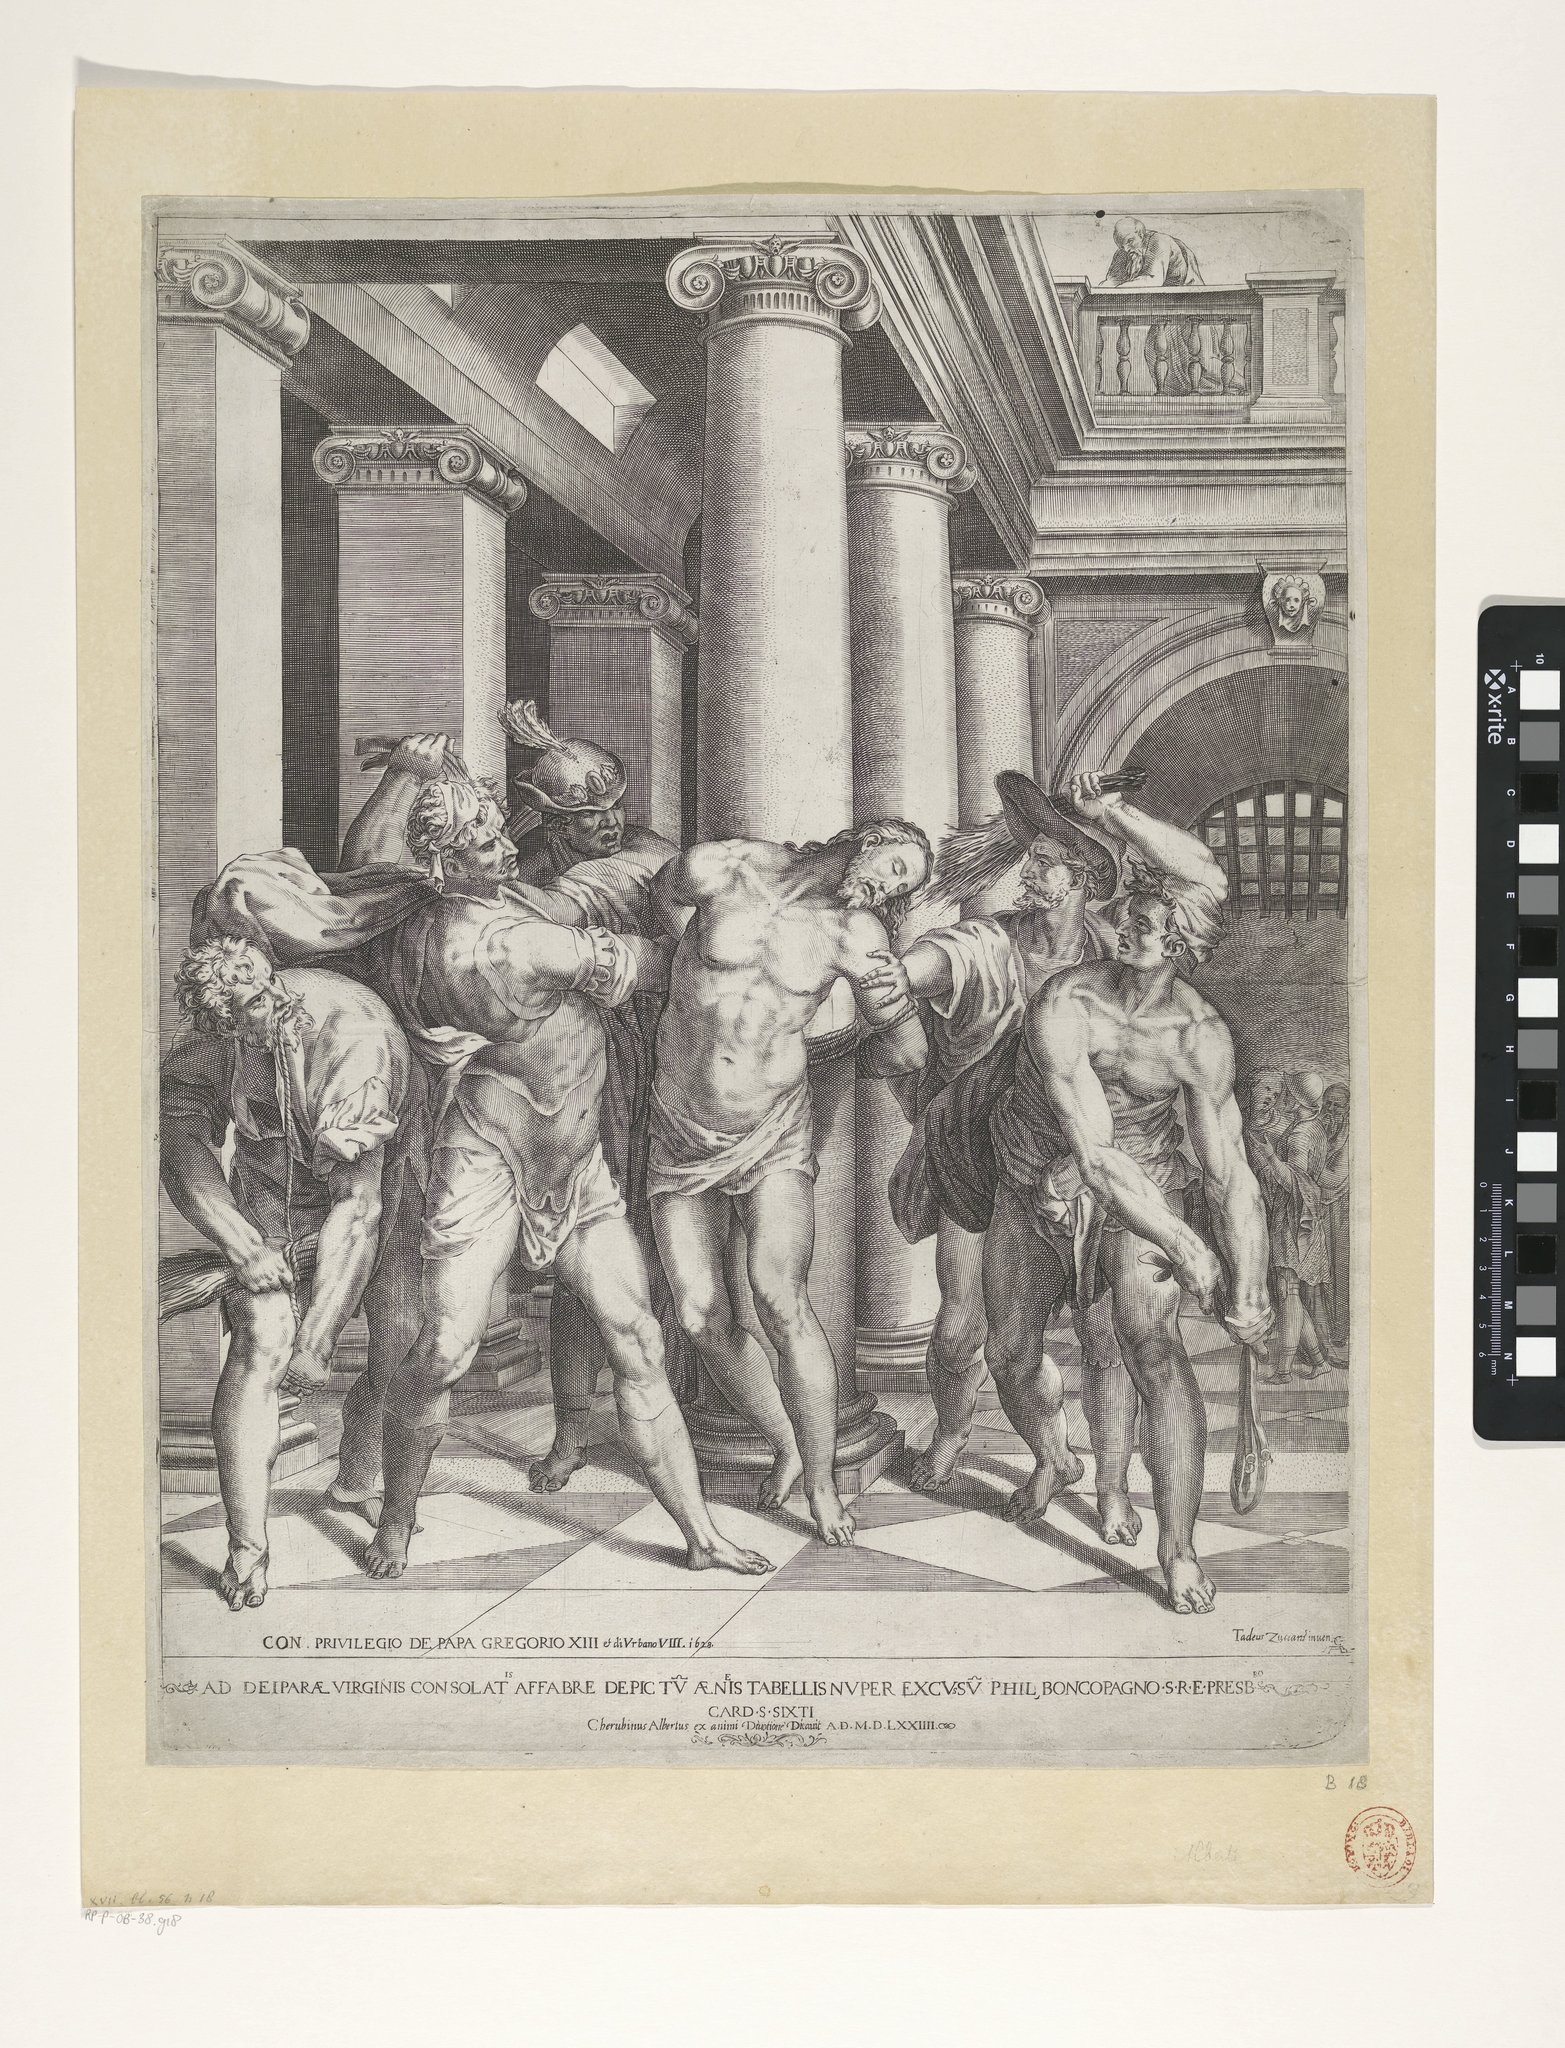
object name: print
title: Geseling van Christus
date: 1563-1615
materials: paper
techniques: engraving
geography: italy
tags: flagellation by soldiers, christ usually tied to a column (matthew 27:26; mark 15:15; john 19:1)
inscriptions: collector's mark: Lugt 240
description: Christus, vastgebonden aan een zuil, wordt door vijf mannen gegeseld.